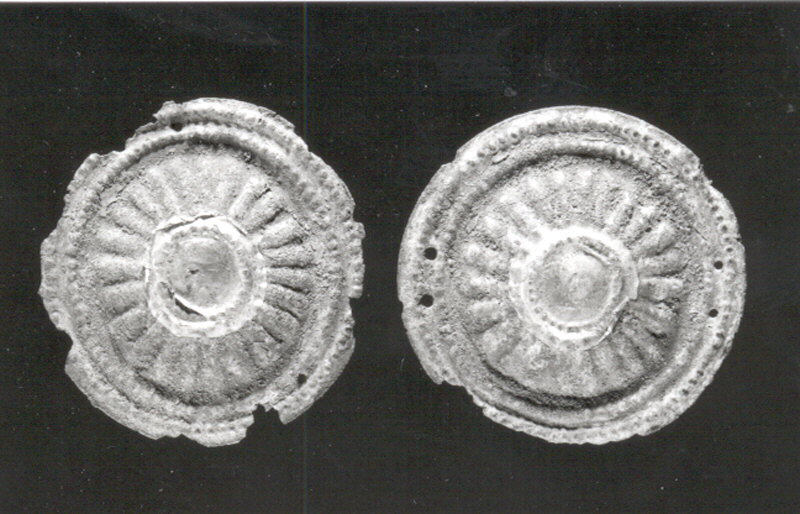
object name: disc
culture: iranian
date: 1000 BCE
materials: bronze, gold